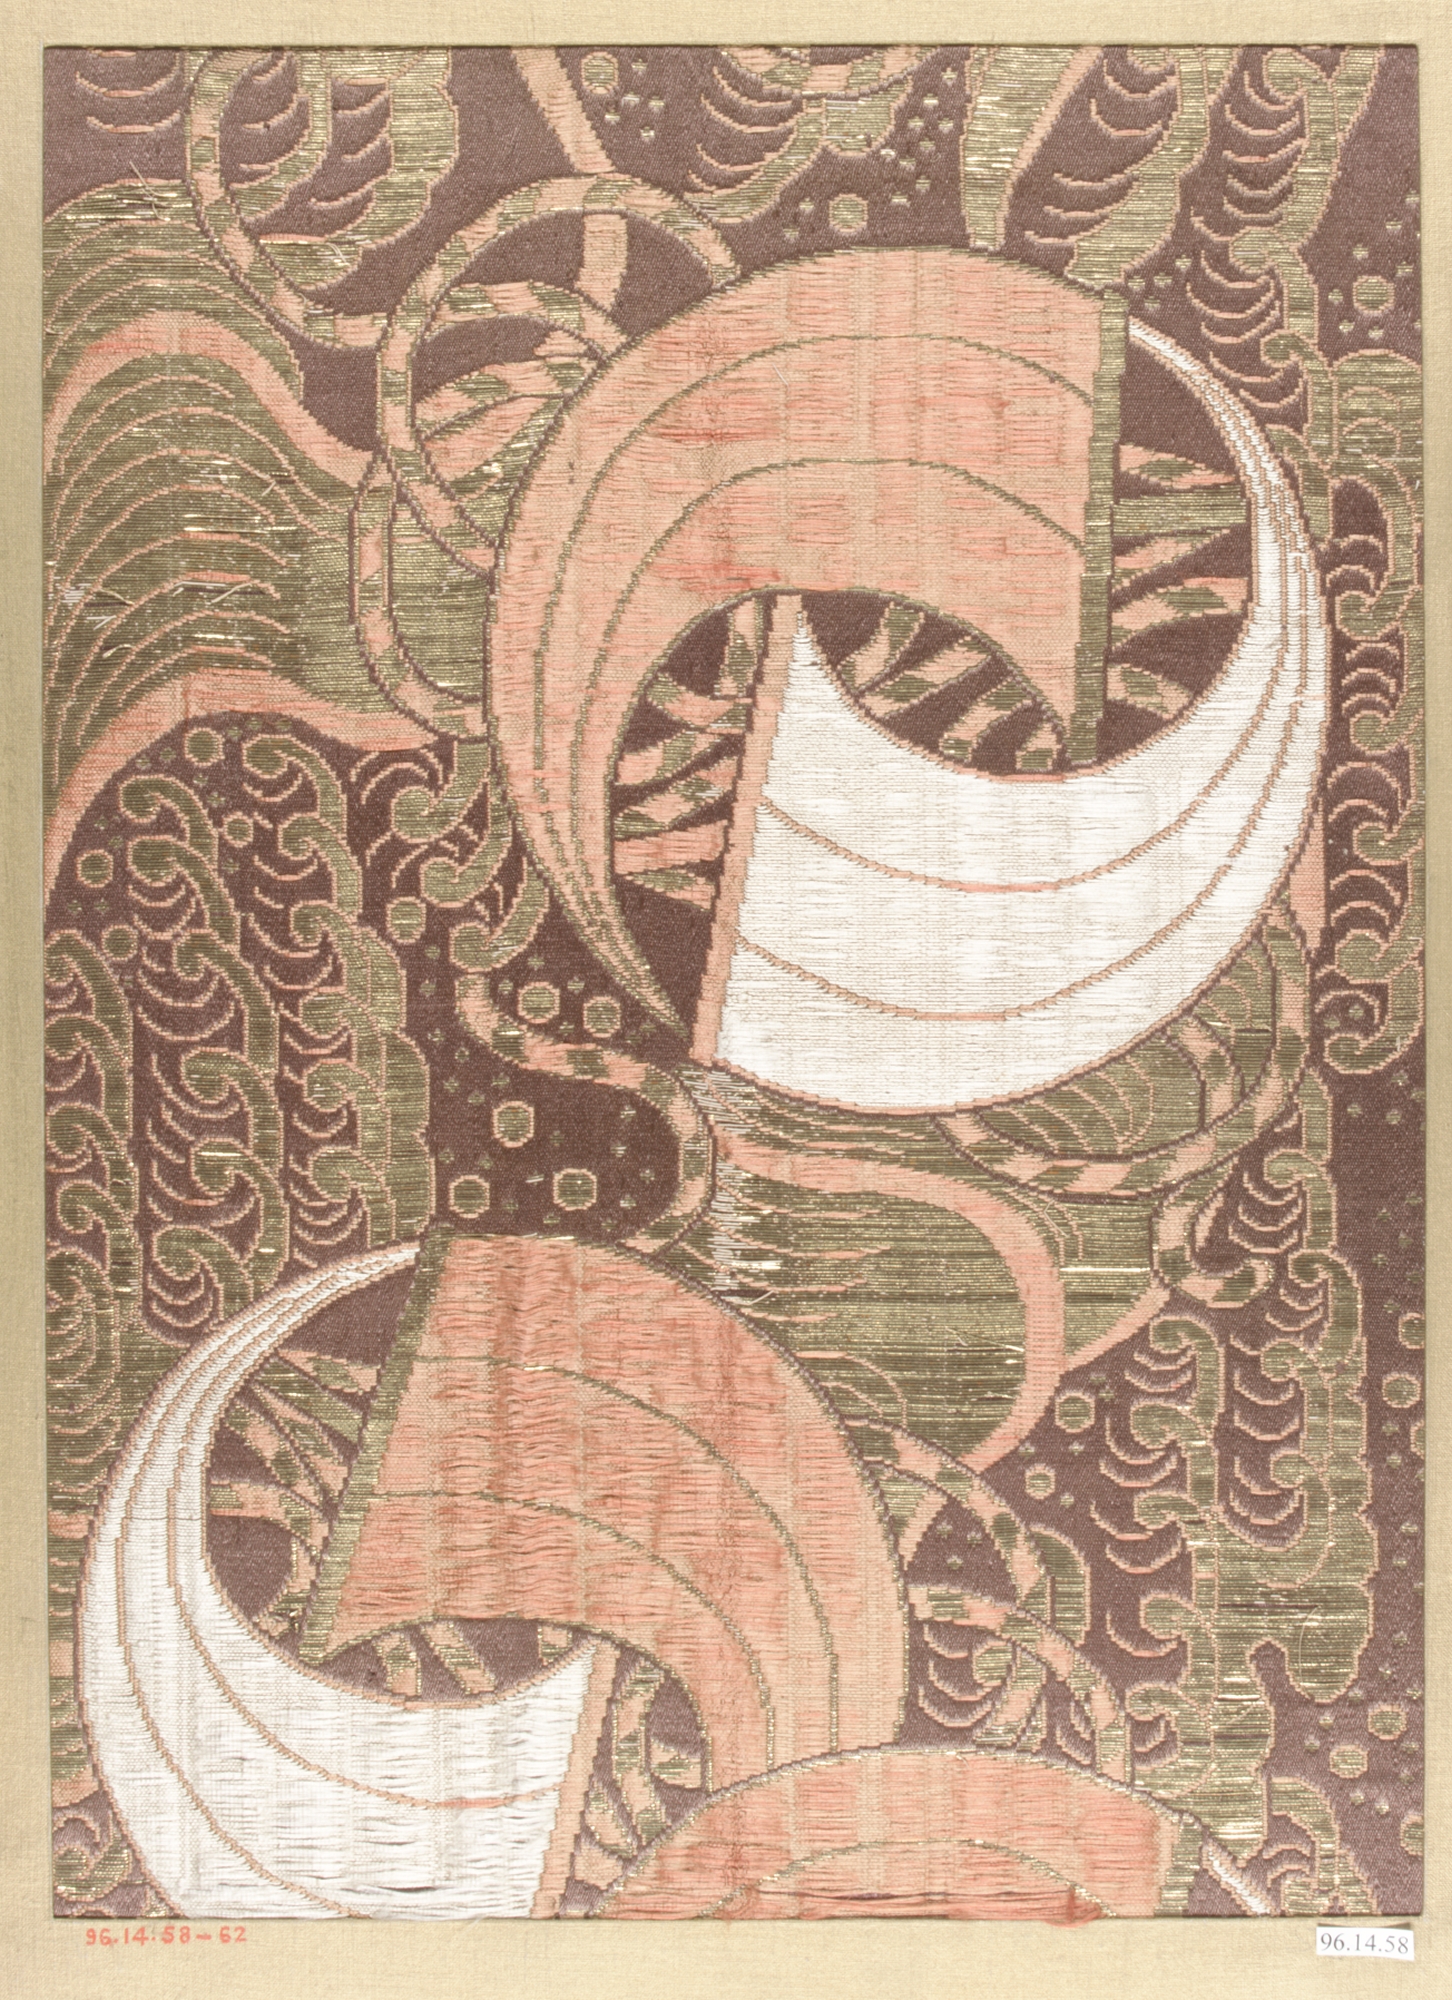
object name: piece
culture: japanese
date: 1701-1800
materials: metal thread, silk